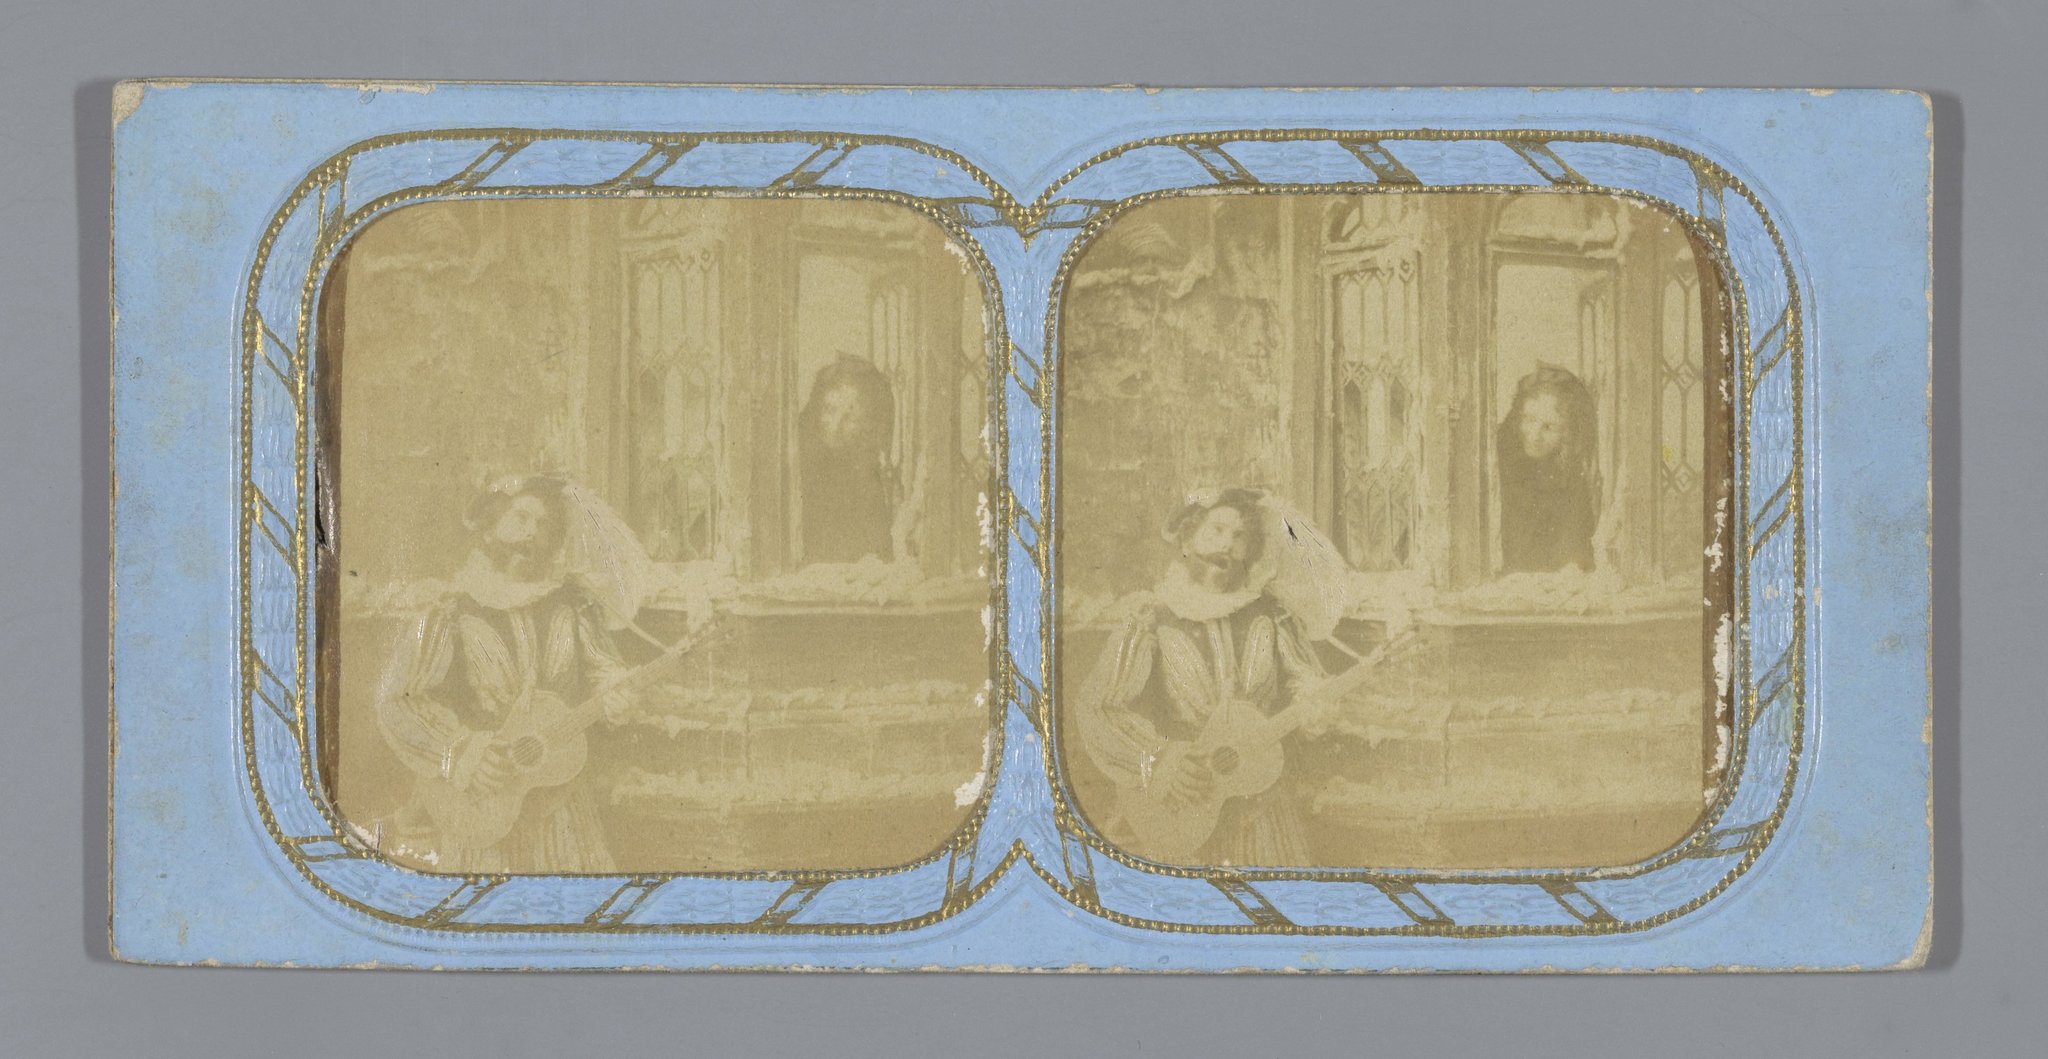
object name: tissue stereograph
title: Man met gitaar zingt voor vrouw in venster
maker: Anonymous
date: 1855-1875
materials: cardboard, paper, photographic support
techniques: albumen print, cutting, hand coloring, perforating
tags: serenade to the beloved